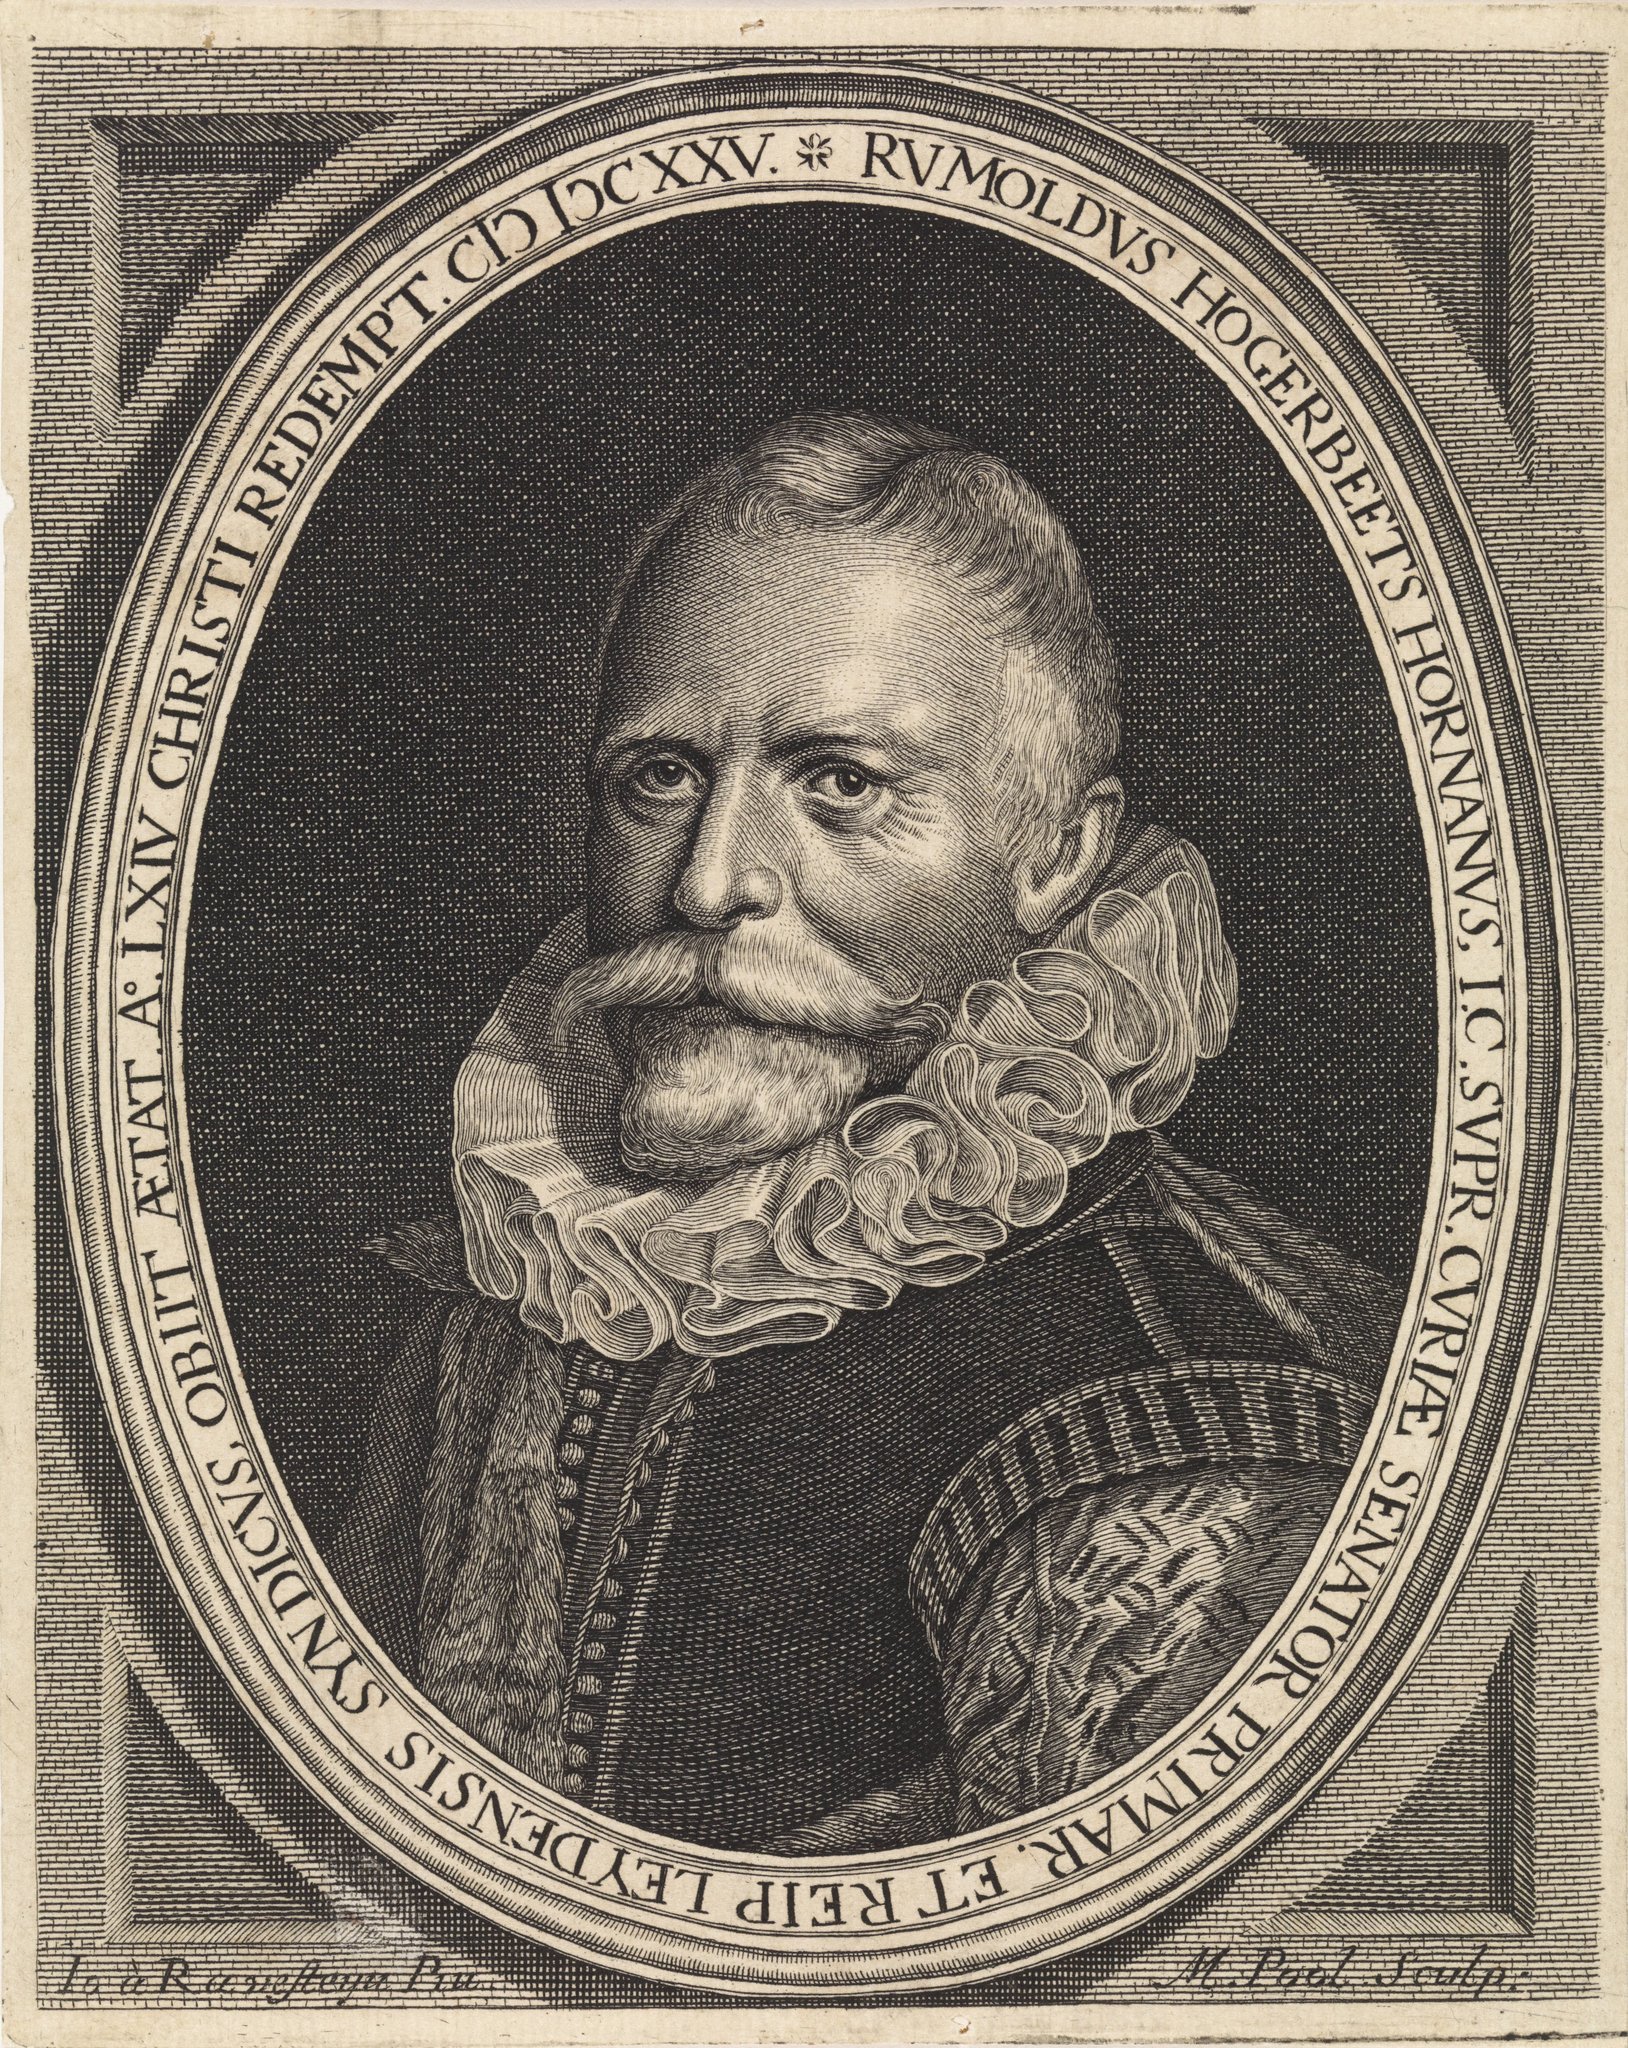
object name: print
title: Portret van Rumoldus Hogerbeets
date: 1696-1727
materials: paper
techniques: engraving, etching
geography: amsterdam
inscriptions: inscription: ‘1561 Hendrick [...] 76.’, collector's mark: Lugt 2228